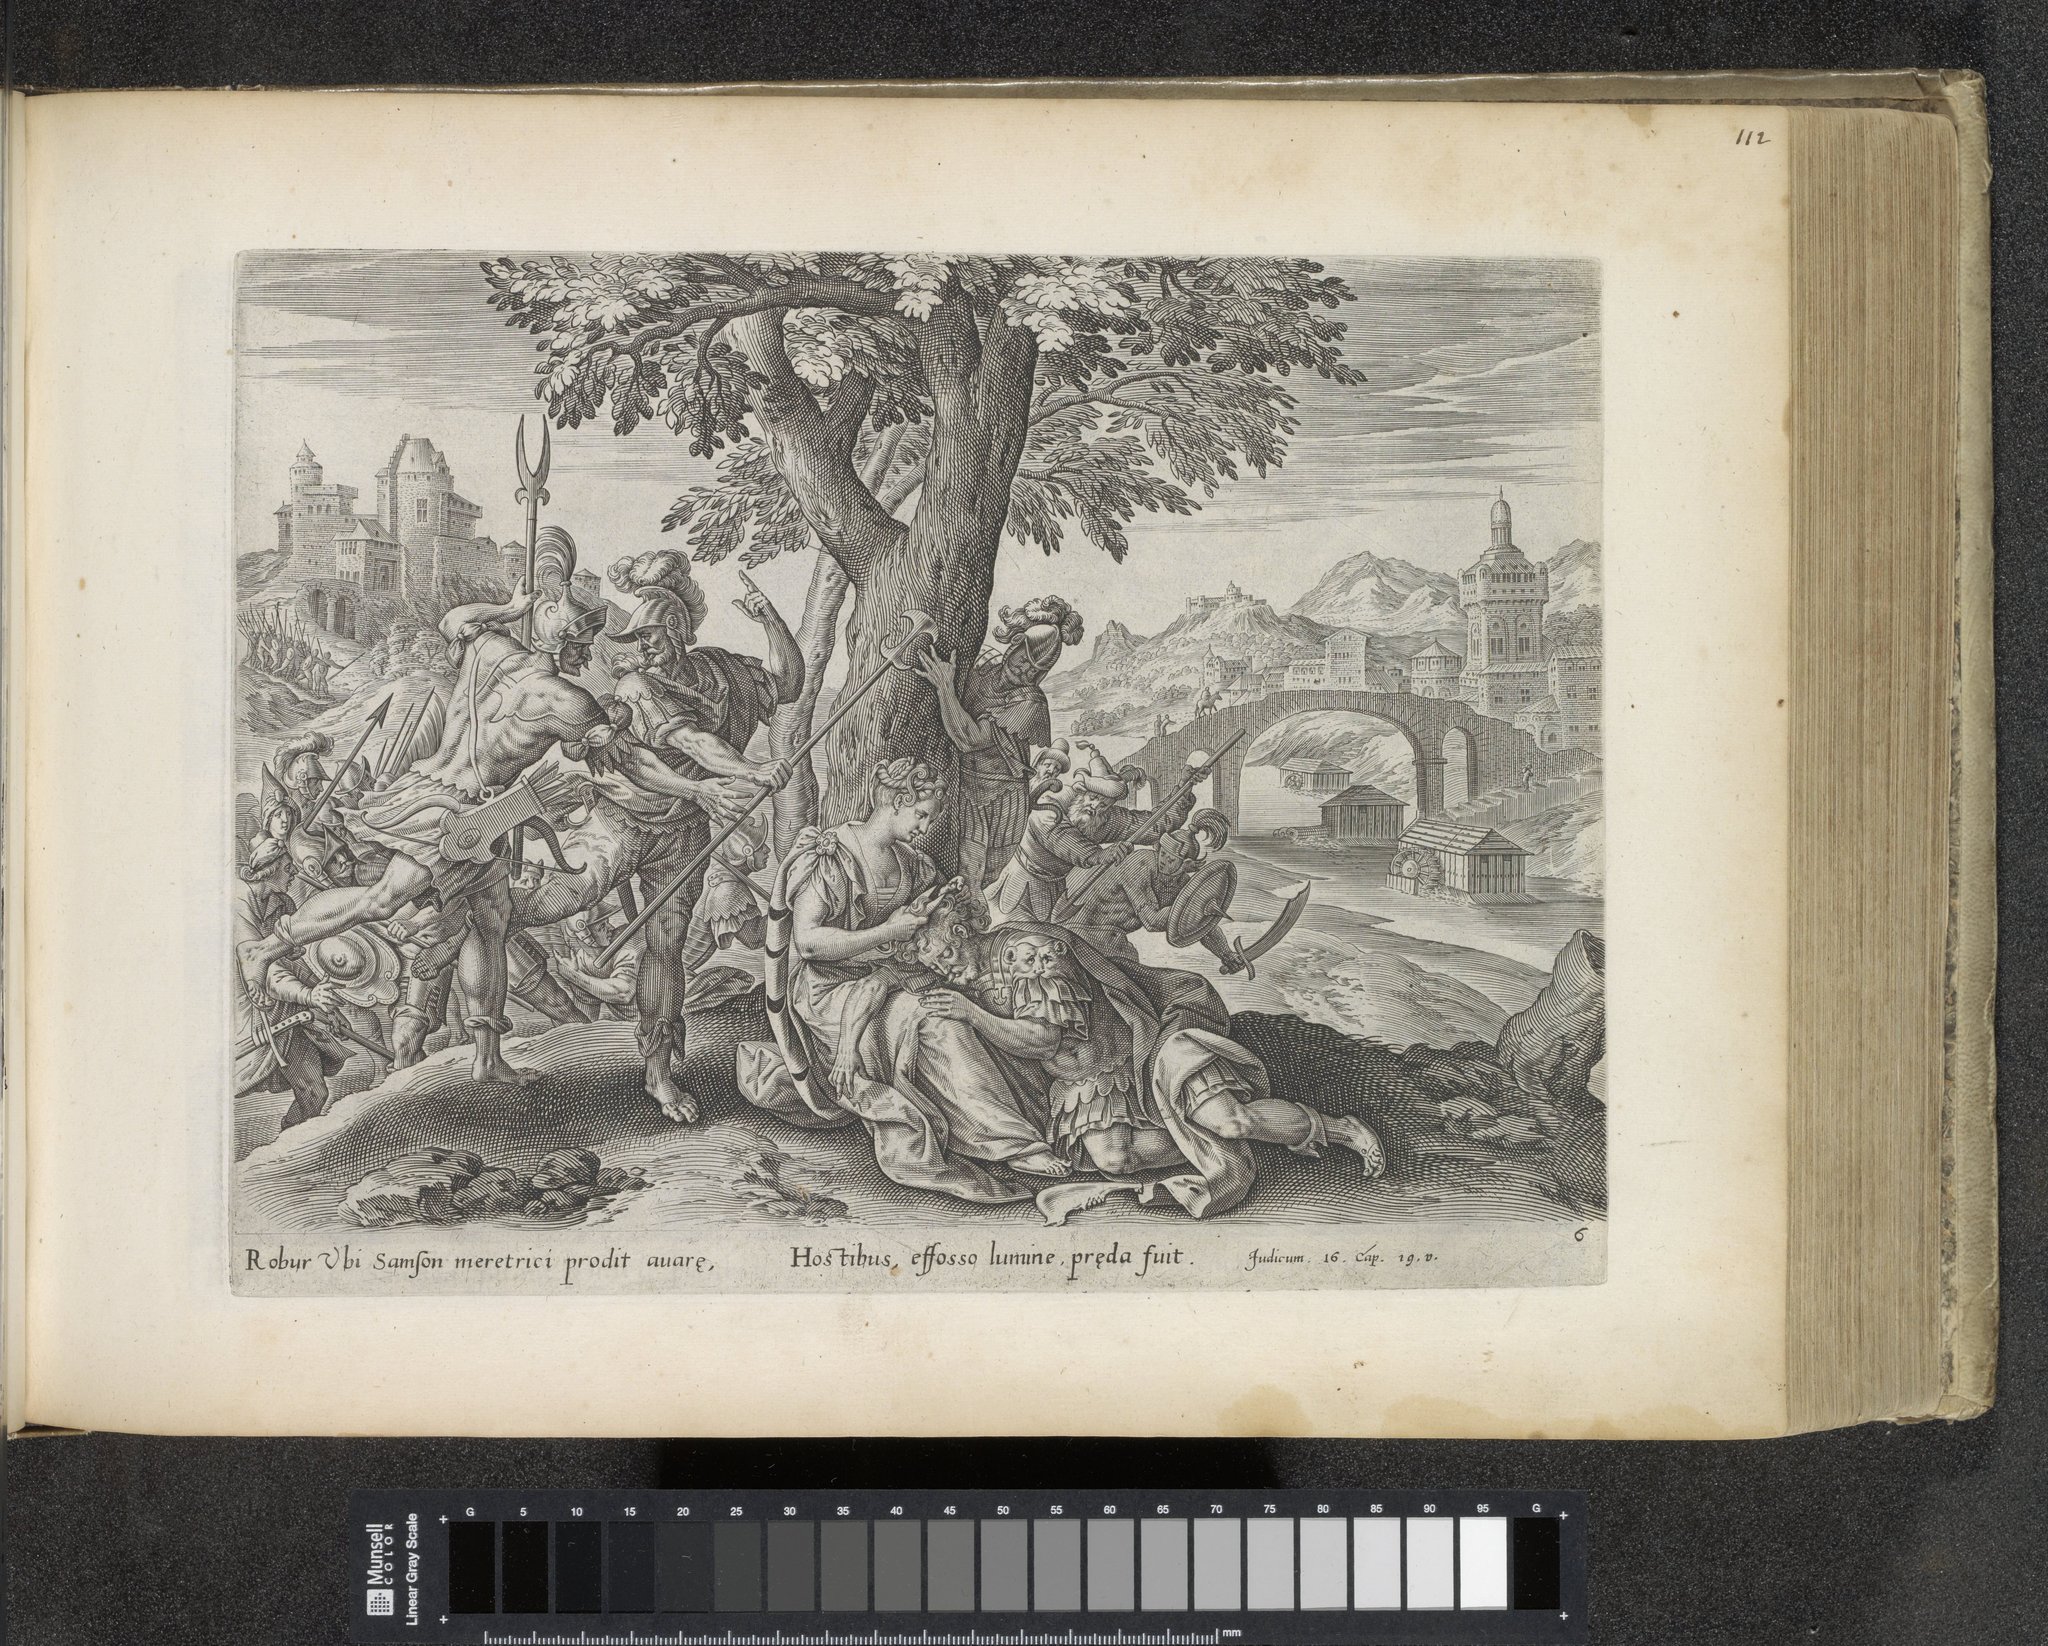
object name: album leaf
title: Geschiedenis van Simson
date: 1585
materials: paper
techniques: engraving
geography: amsterdam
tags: samson's hairlocks are cut off by delilah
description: Simson ligt te slapen op Delila's schoot en zij knipt zijn haren af. Gewapende Filstijnen komen tevoorschijn achter de boom om Simson gevangen te nemen. Rechts in het landschap een brug over een rivier. Onder de voorstelling een verwijzing in het Latijn naar de Bijbeltekst in Ri. 16:19. Deze prent maakt deel uit van een album.